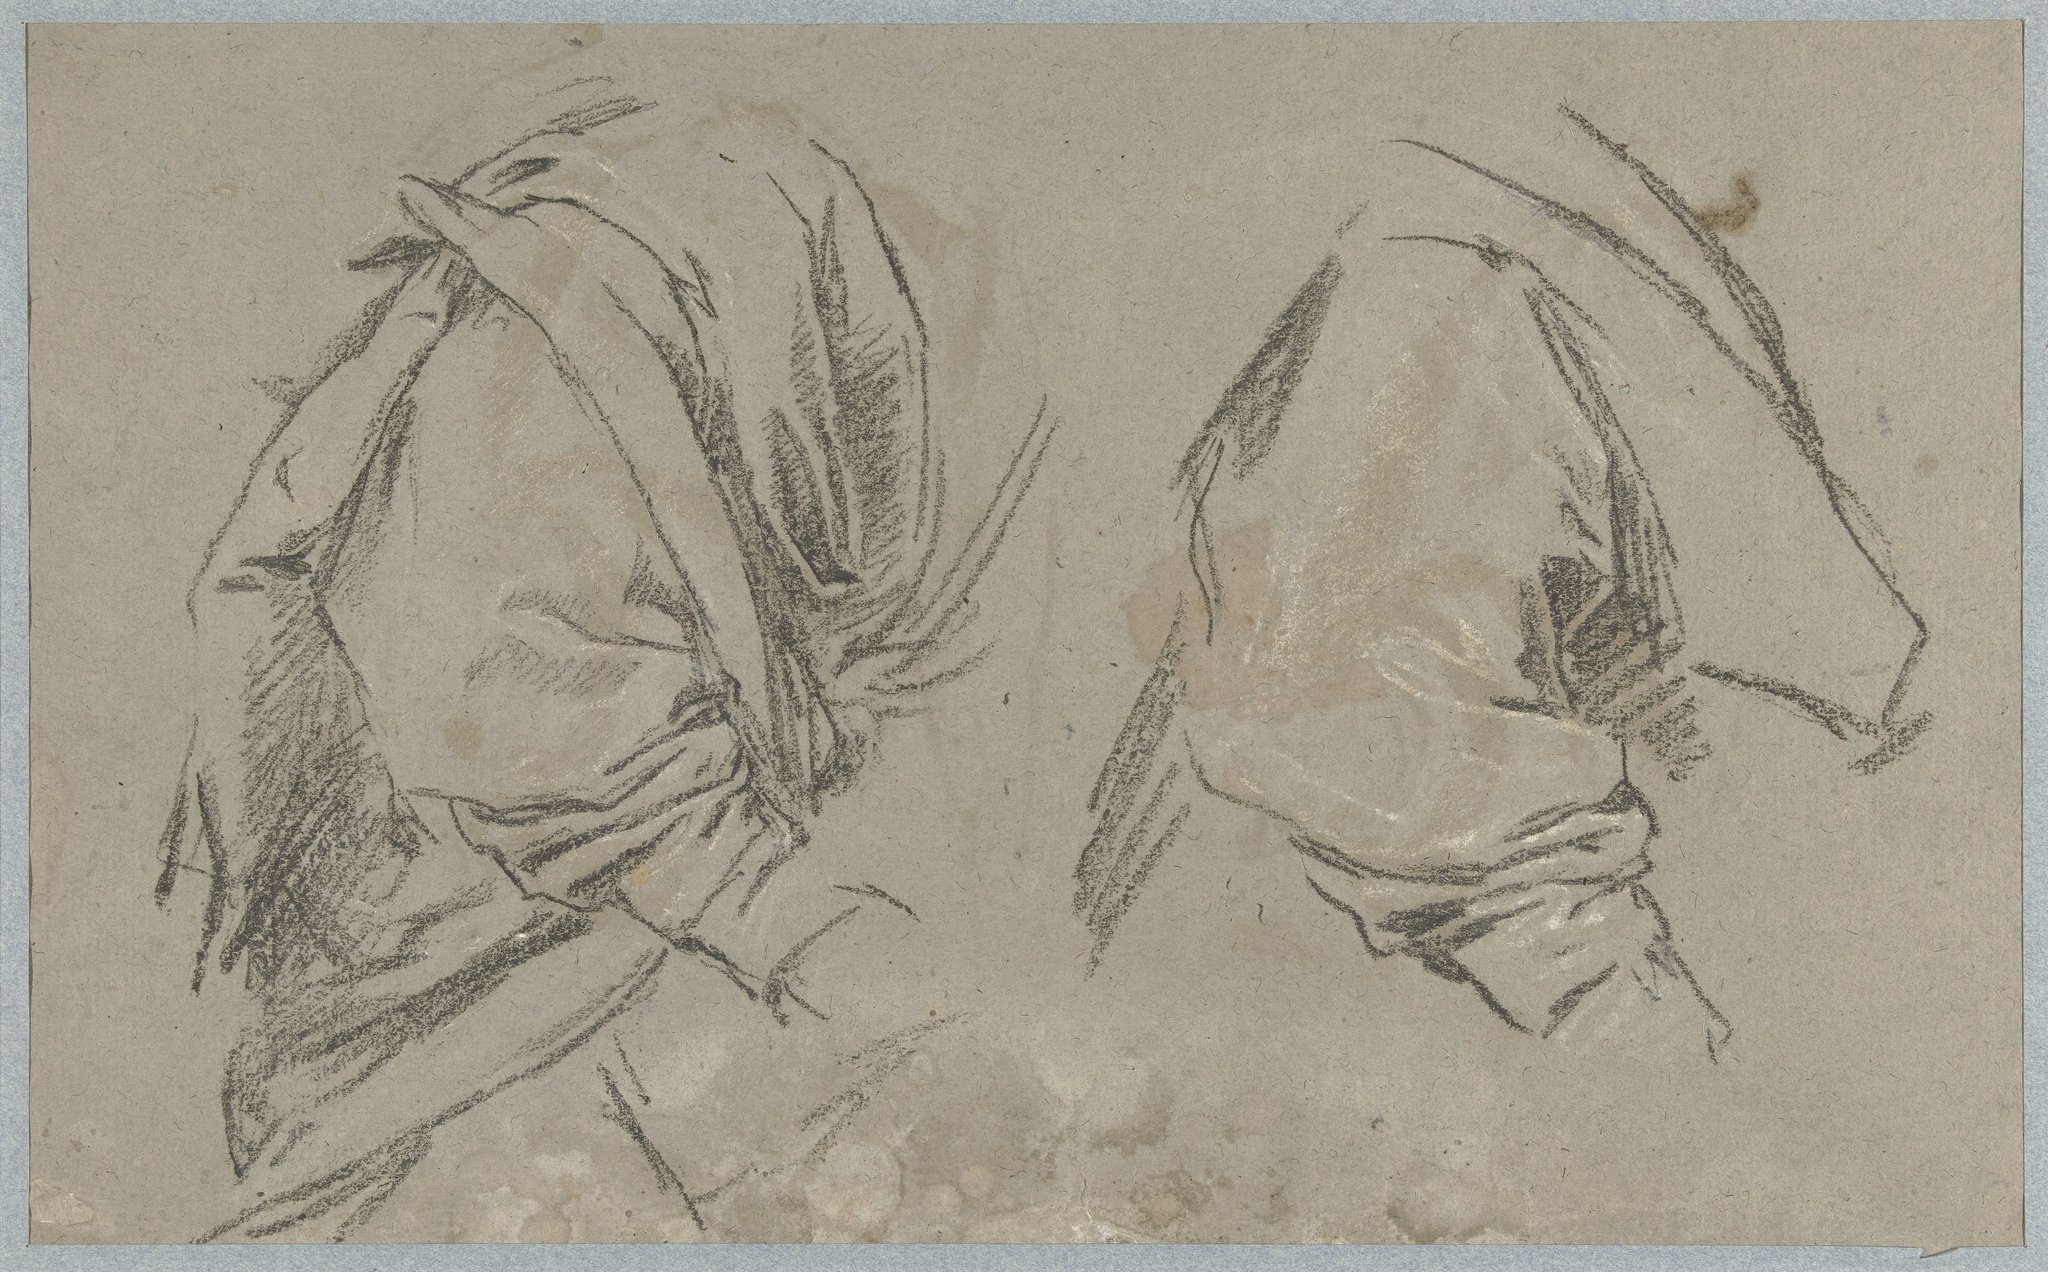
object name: drawing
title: Twee studies van een arm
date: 1588-1660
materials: chalk, paper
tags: arms, drapery, draped garment, 'gewandgebung'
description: Twee studies van een arm, in een mouw van een priestergewaad.